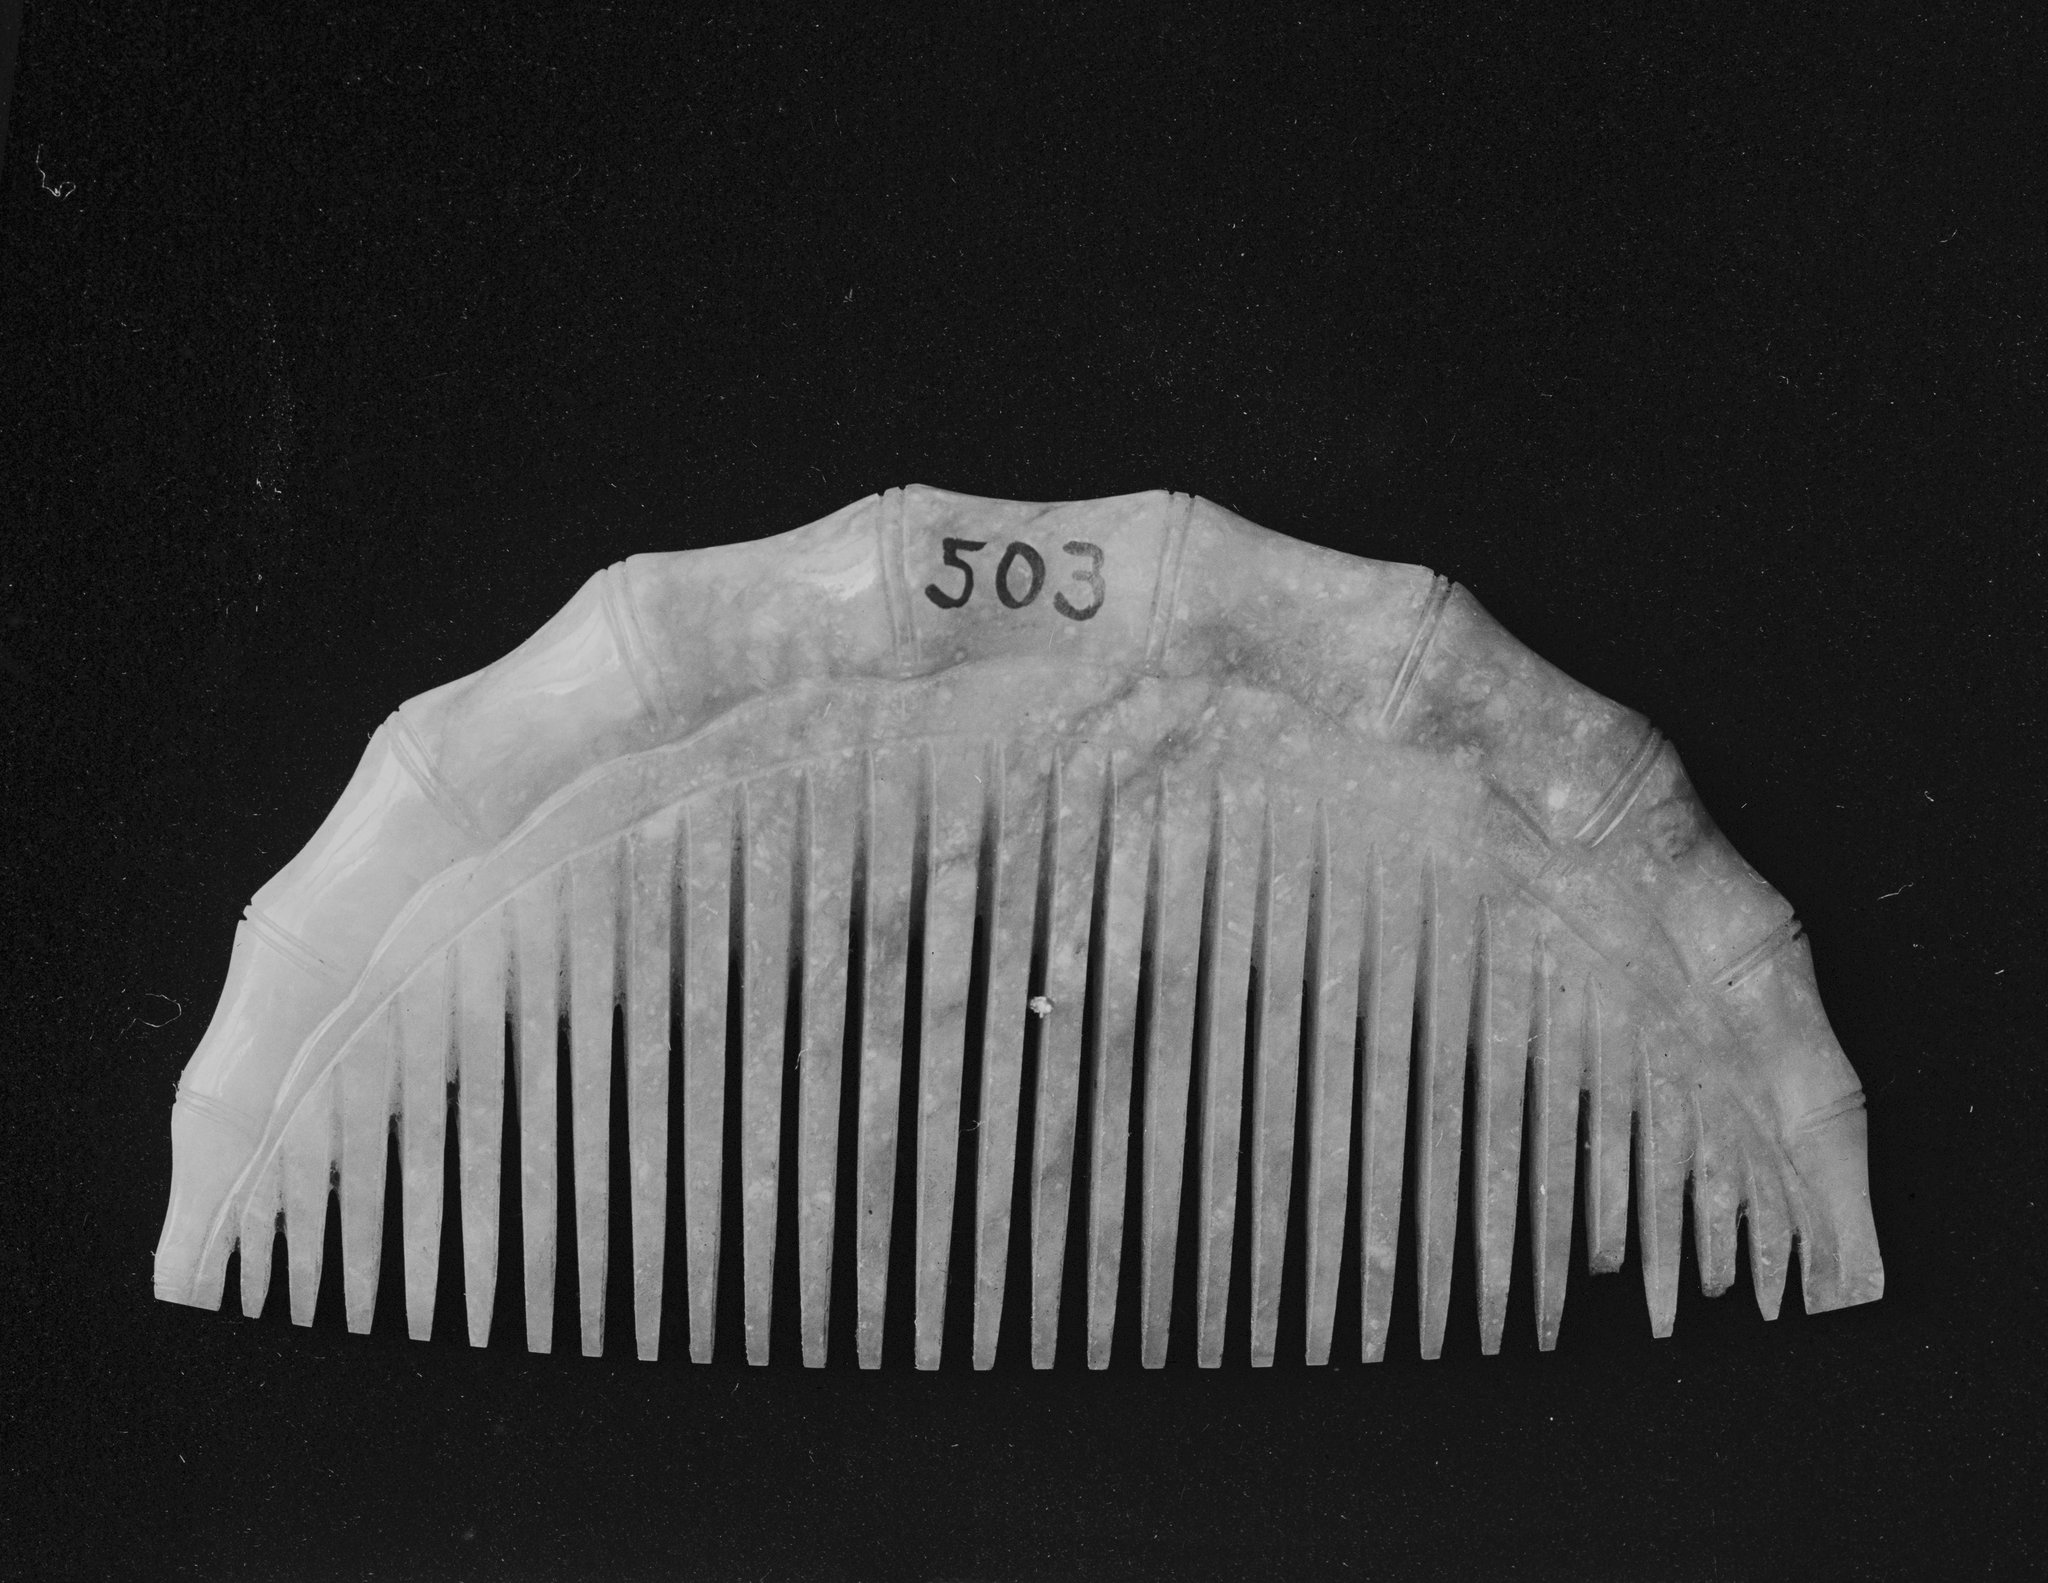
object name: comb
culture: chinese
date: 1736-1795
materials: gemstone, jade